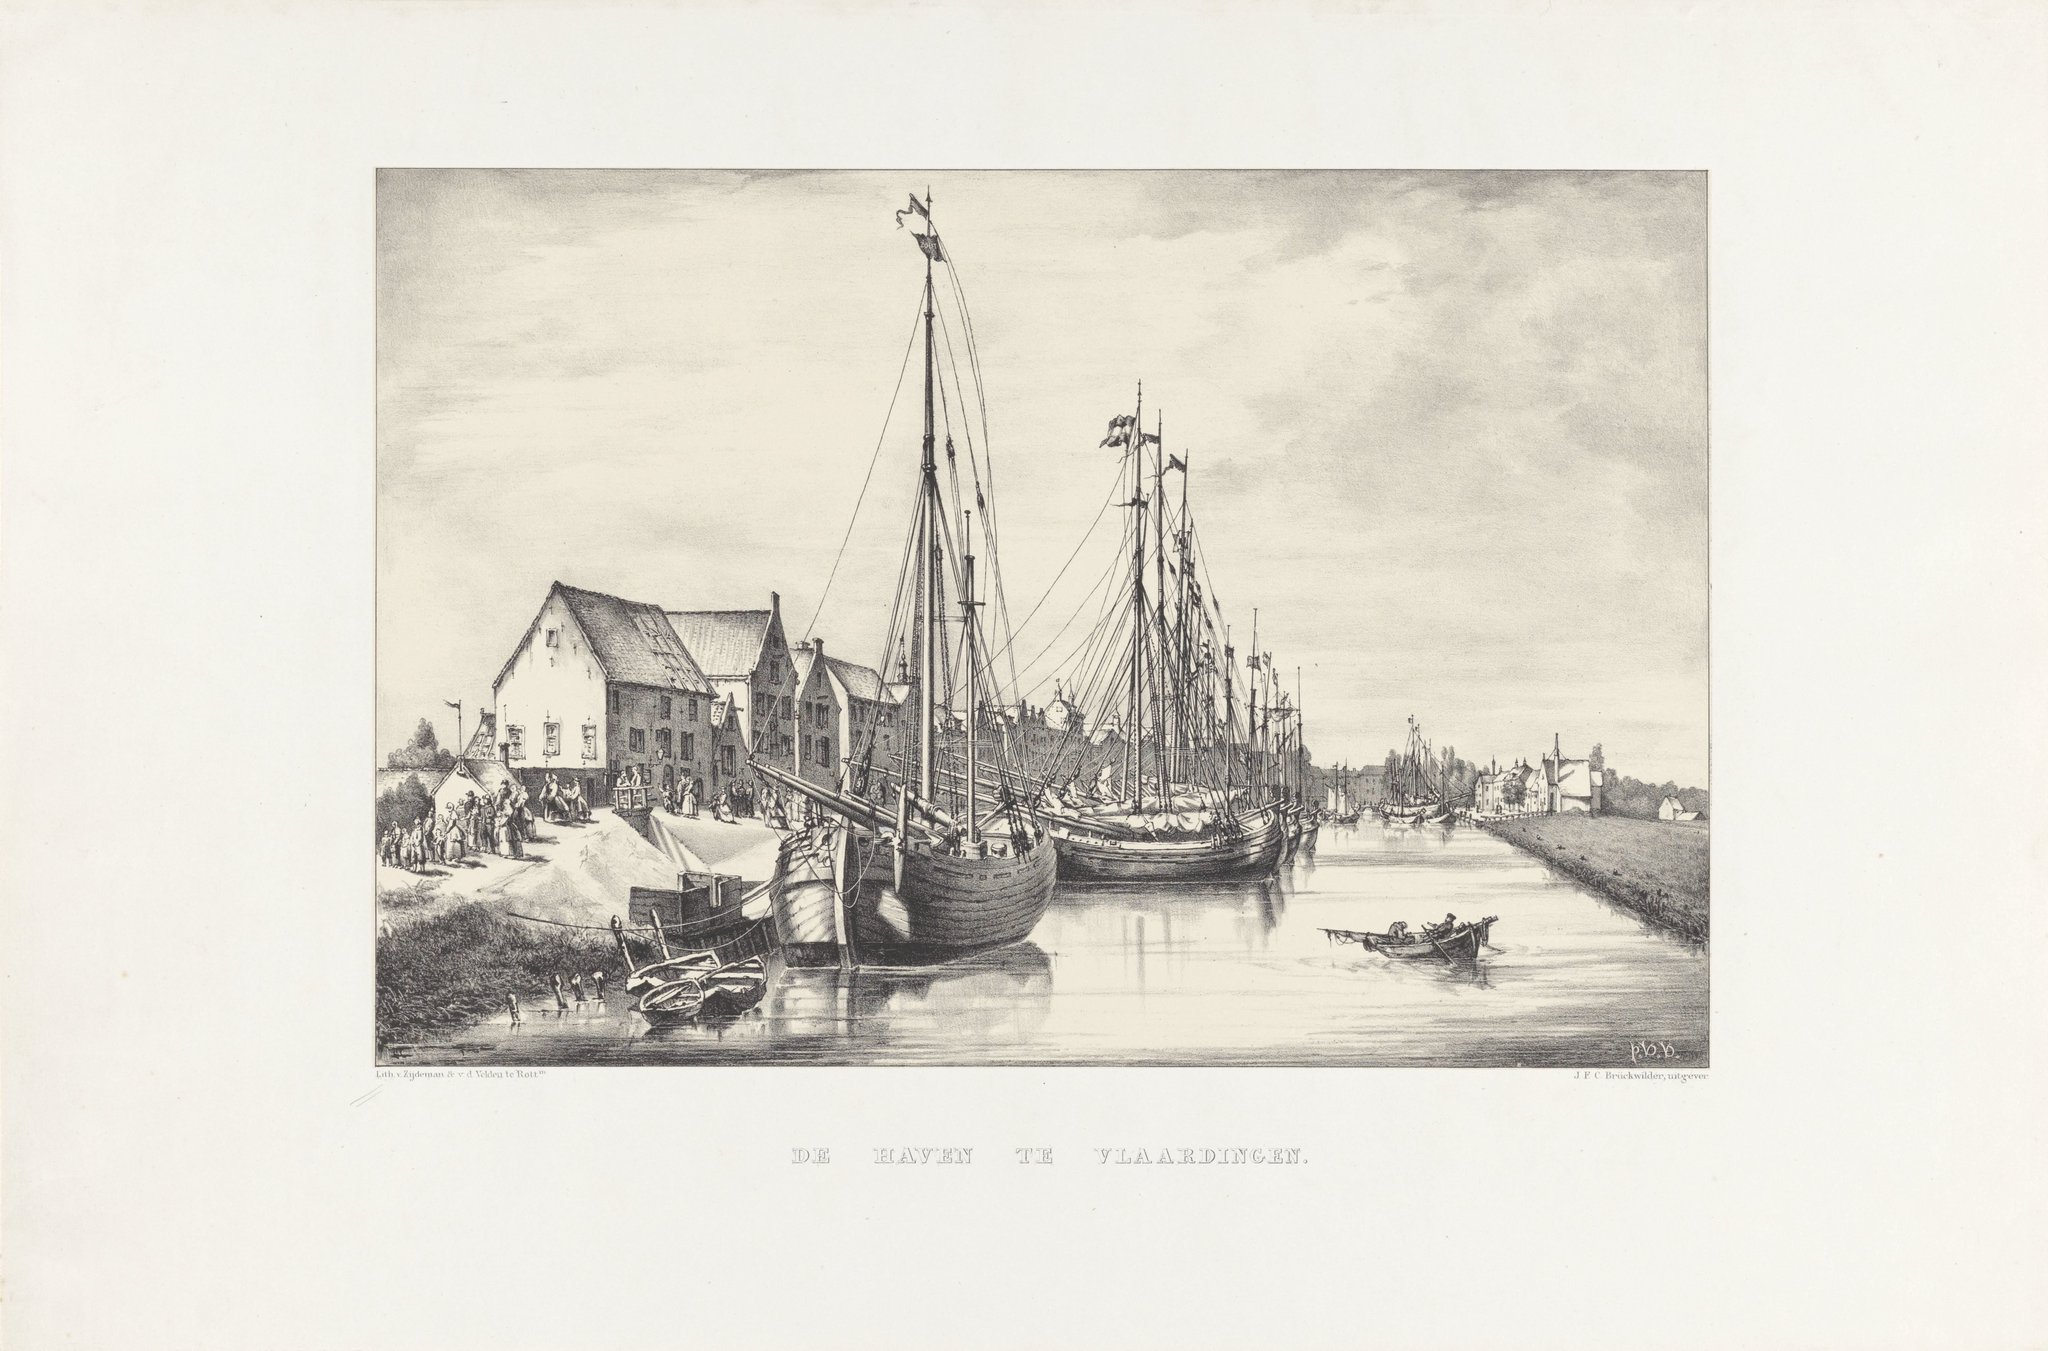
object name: print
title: Gedenkplaat 50 jaar na het uitzeilen van de eerste haringvloot na de herstelling van Nederlands onafhankelijkheid, 1864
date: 1864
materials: paper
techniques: tone lithography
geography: rotterdam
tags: harbour, herring fishery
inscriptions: collector's mark: Lugt 2228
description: Historische voorstelling van de haven van Vlaardingen in de zeventiende eeuw. Gedenkplaat bij het 50jarige jubileum van het in 1814 uitzeilen van de eerste haringvloot na het herstel van Nederlands onafhankelijkheid, 24 juni 1864.